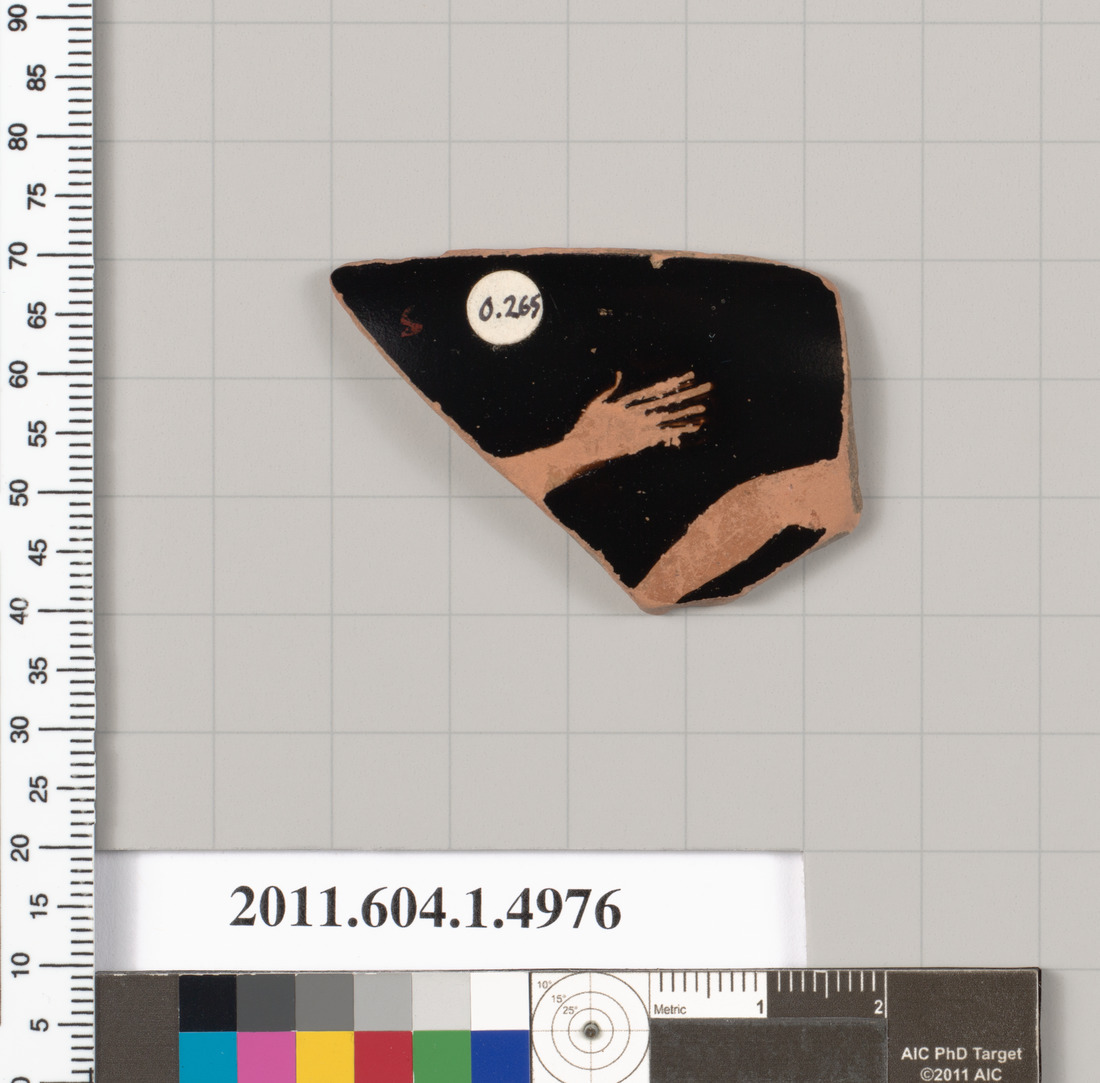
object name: kylix fragment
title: Terracotta rim fragment of a kylix (drinking cup)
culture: greek, attic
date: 500-480 BCE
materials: terracotta